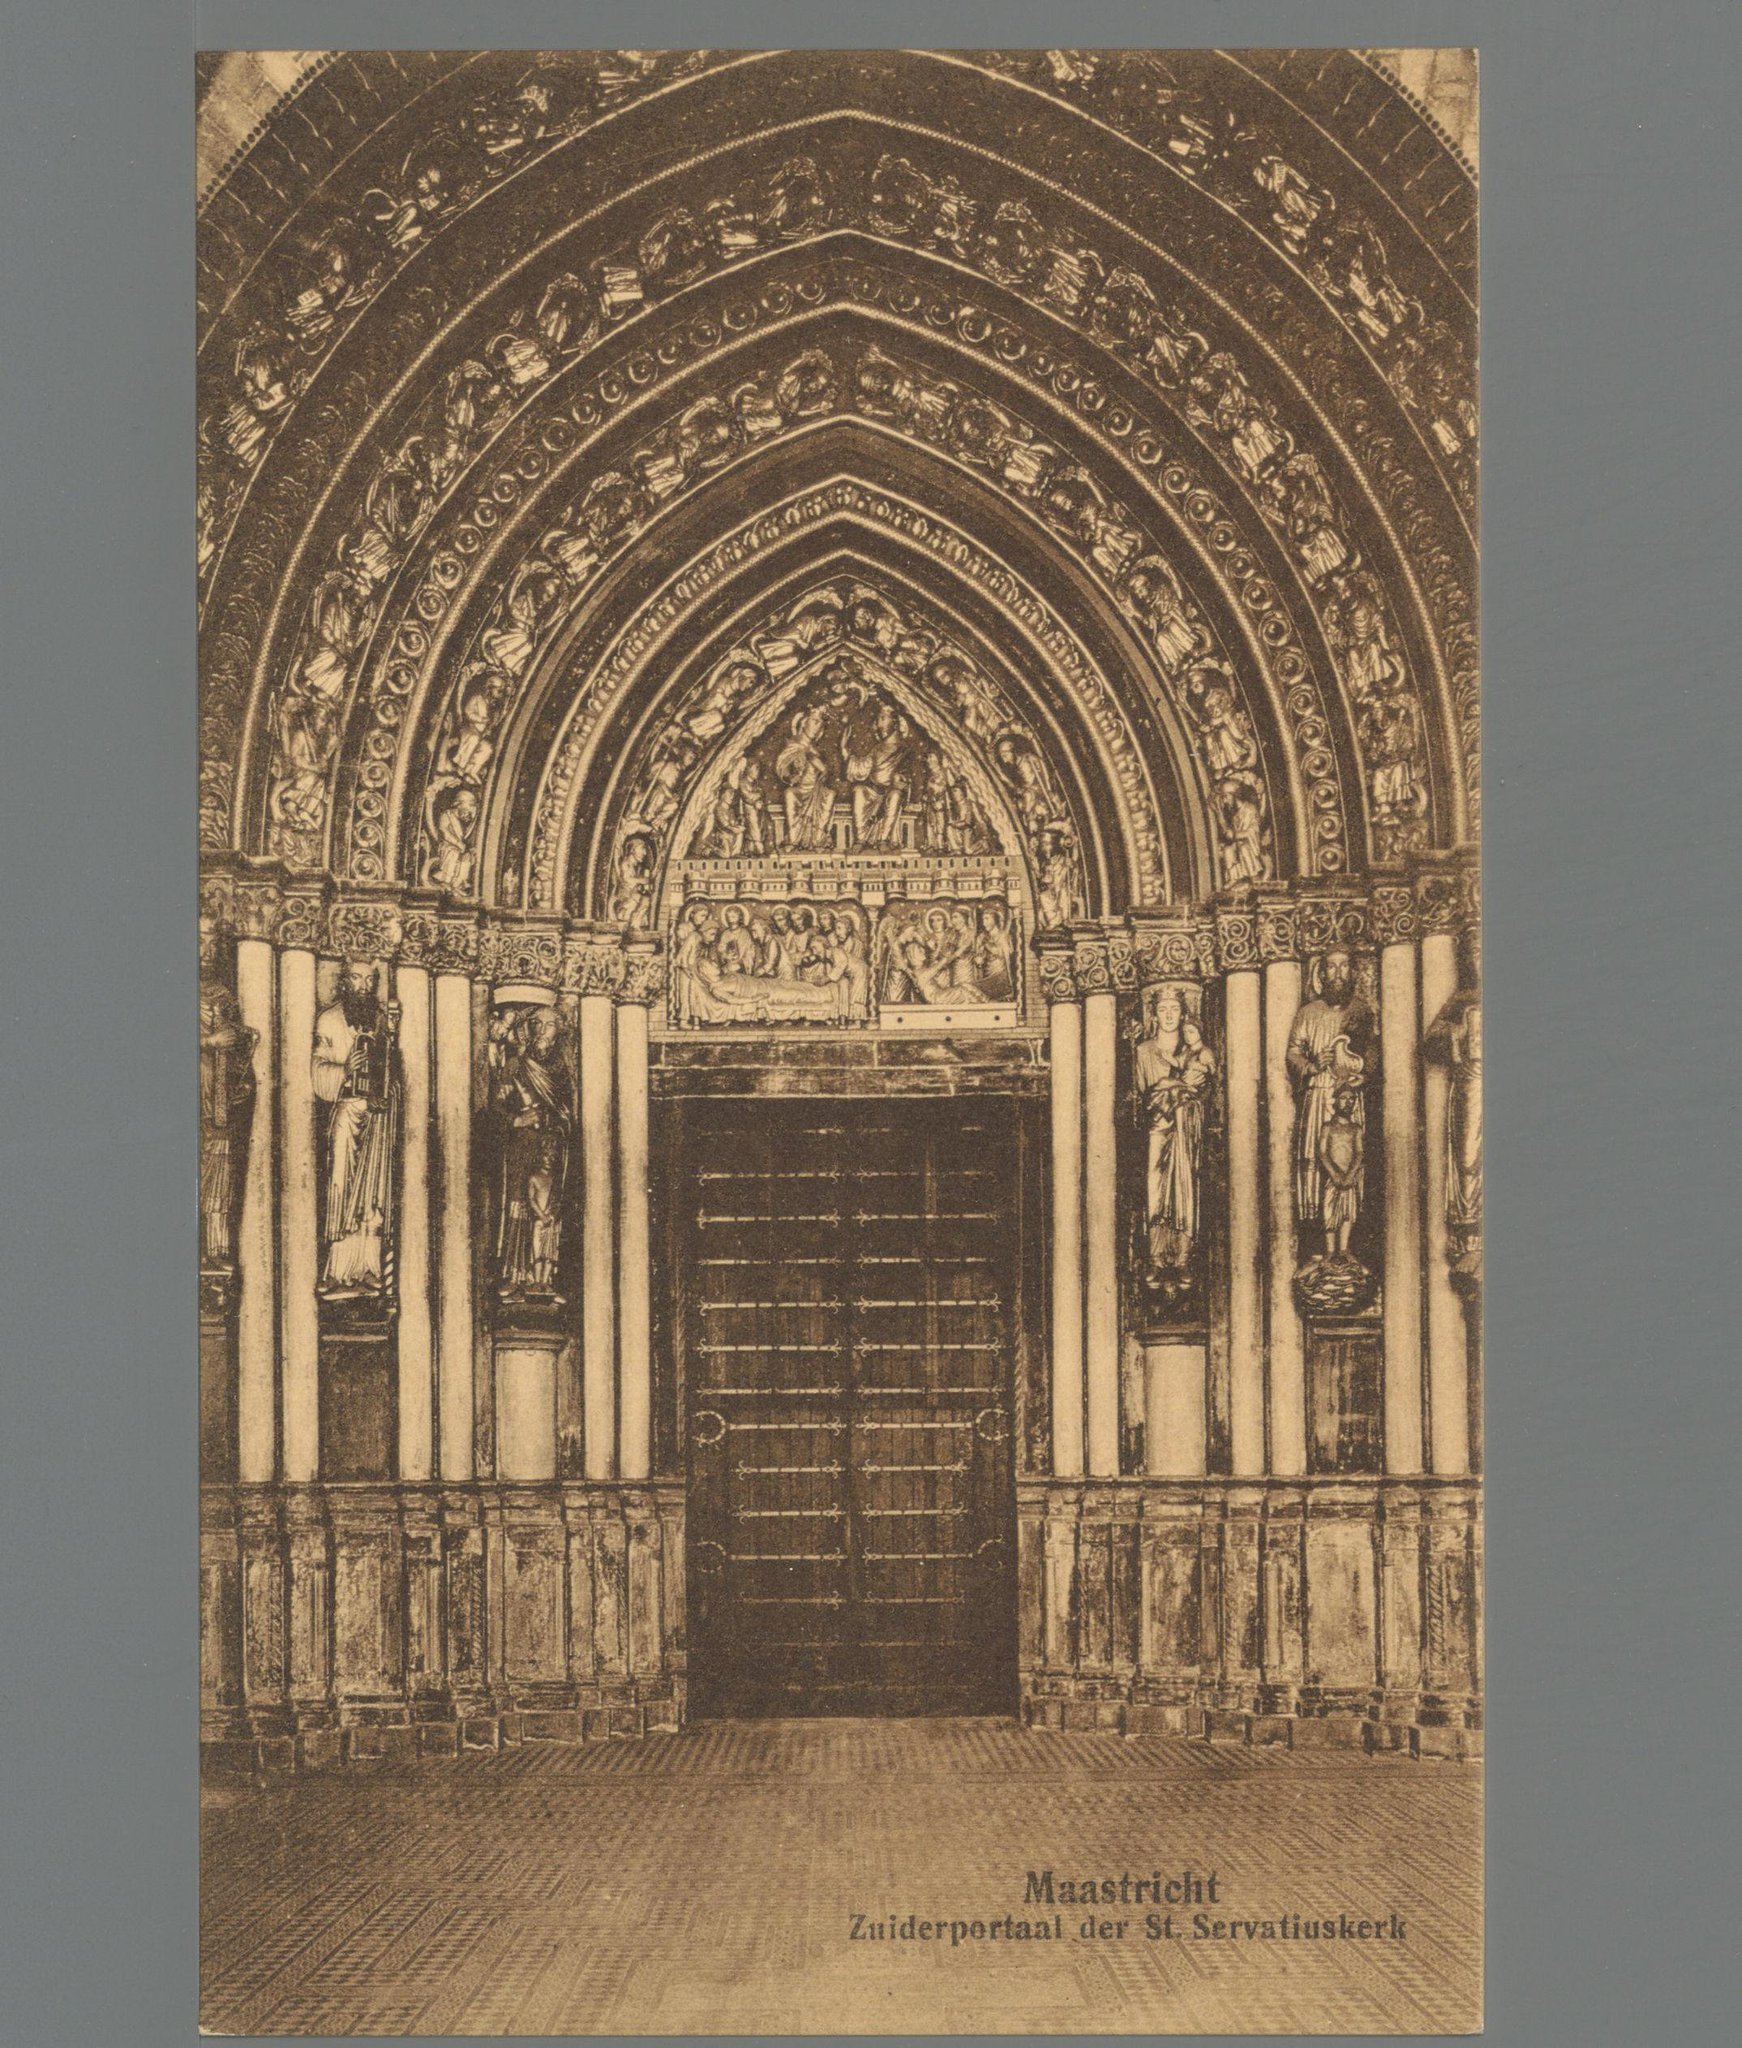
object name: photomechanical print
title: Maastricht. Zuiderportaal der St. Servatiuskerk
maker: Anonymous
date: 1912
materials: cardboard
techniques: photograph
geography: maastricht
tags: gate, entrance, interior of church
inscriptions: date